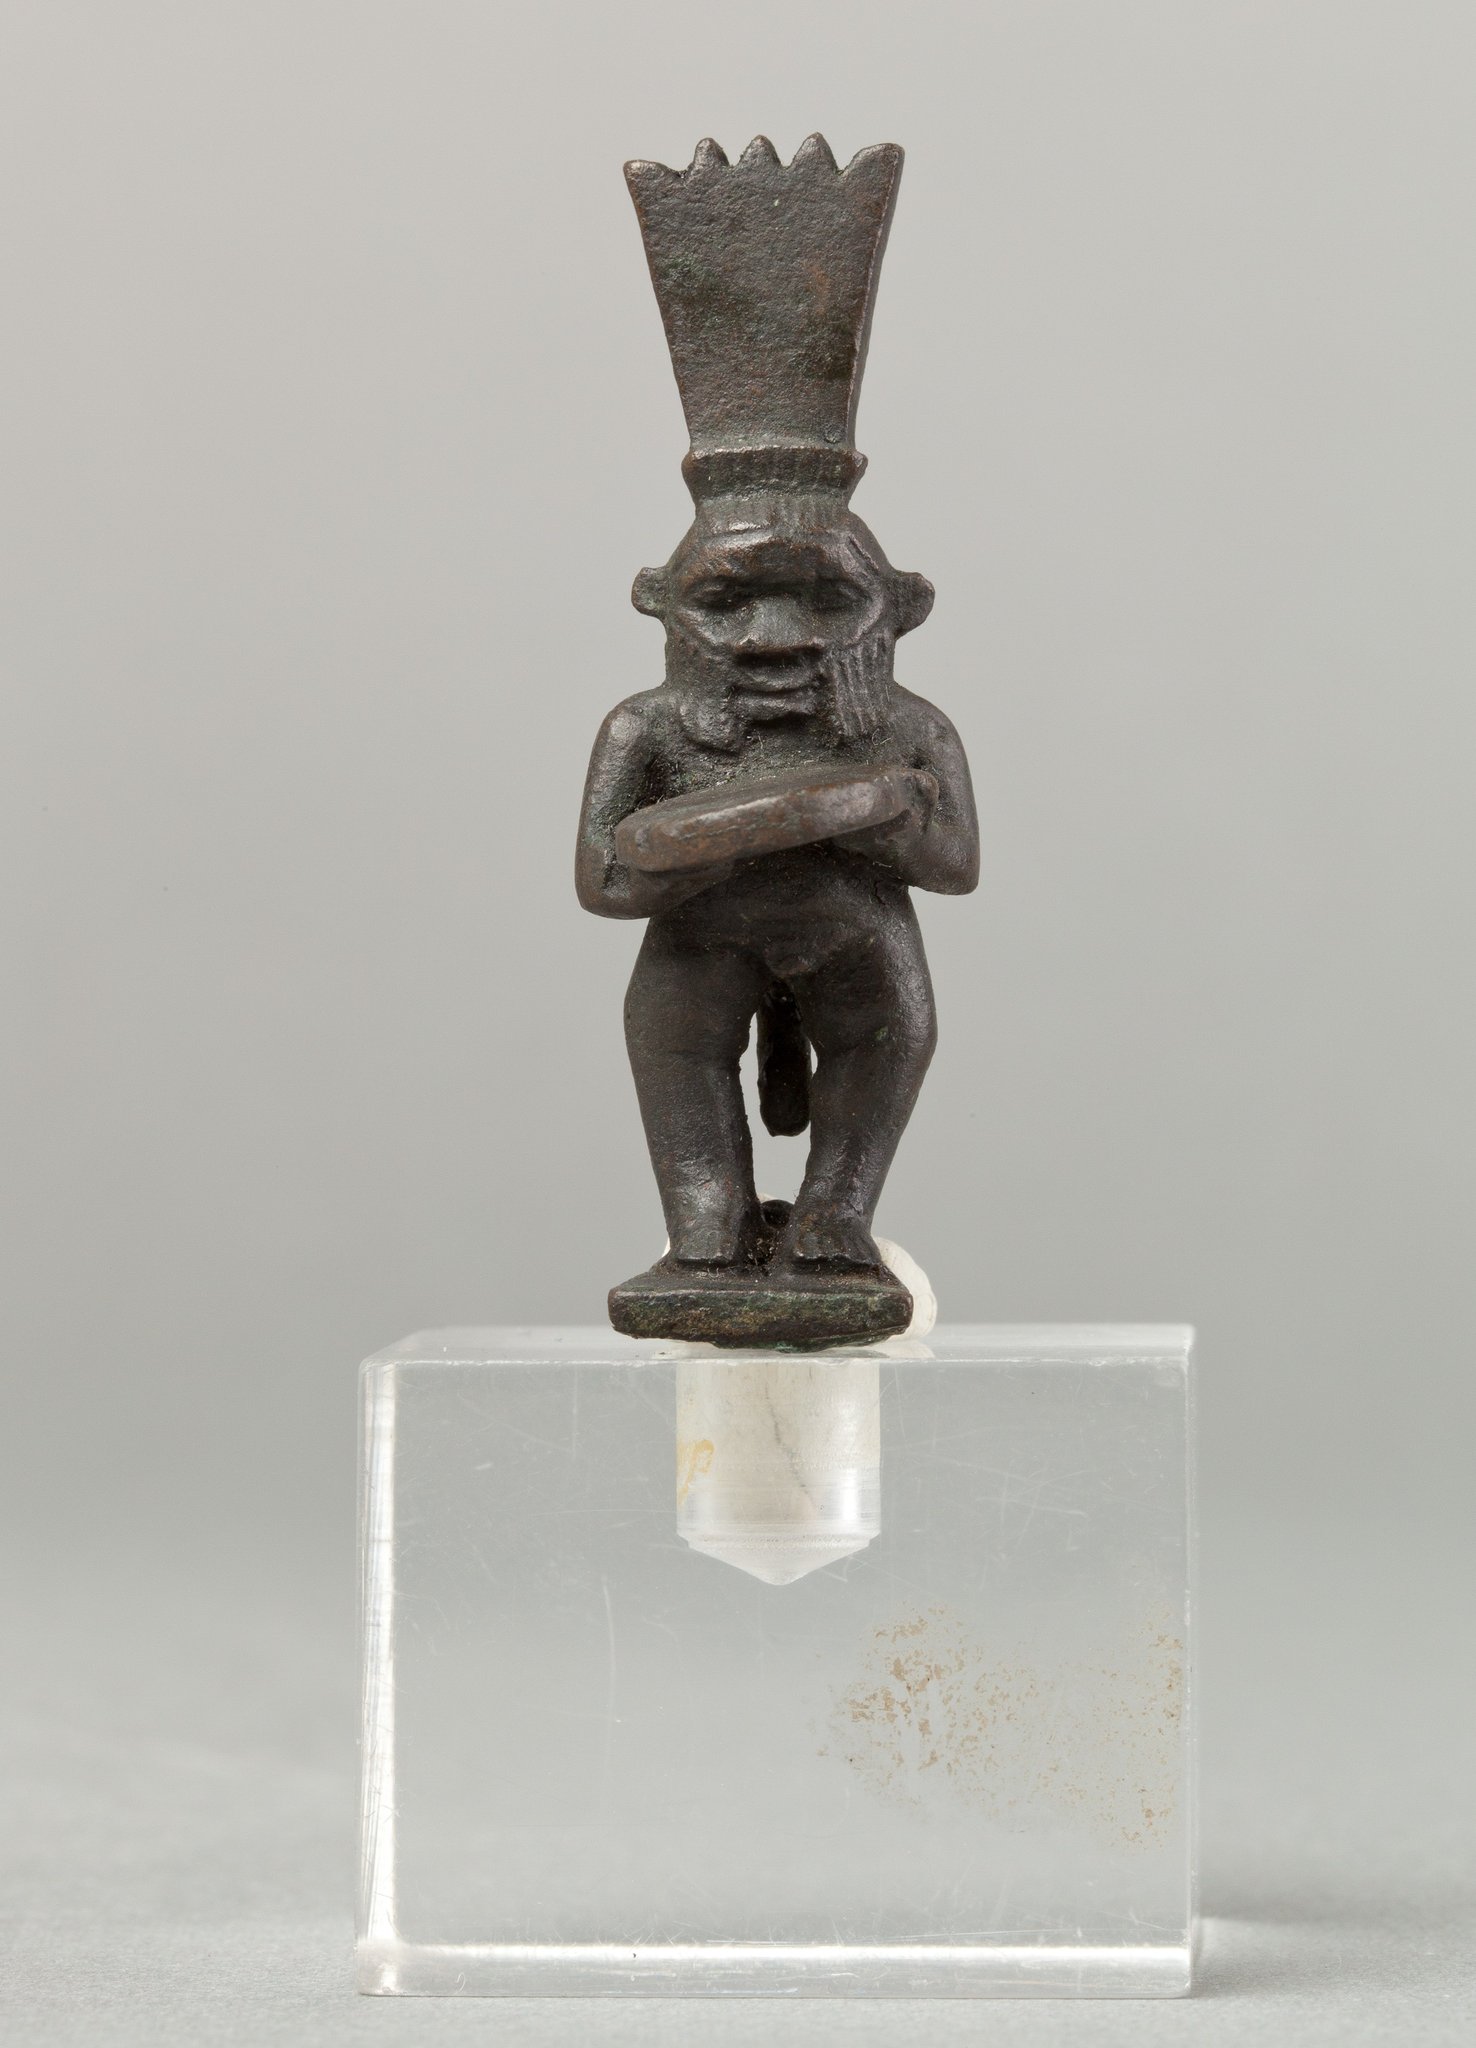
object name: amulet, be, tambourine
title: Bes with a tambourine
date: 664-630 BCE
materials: metal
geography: egypt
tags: bes